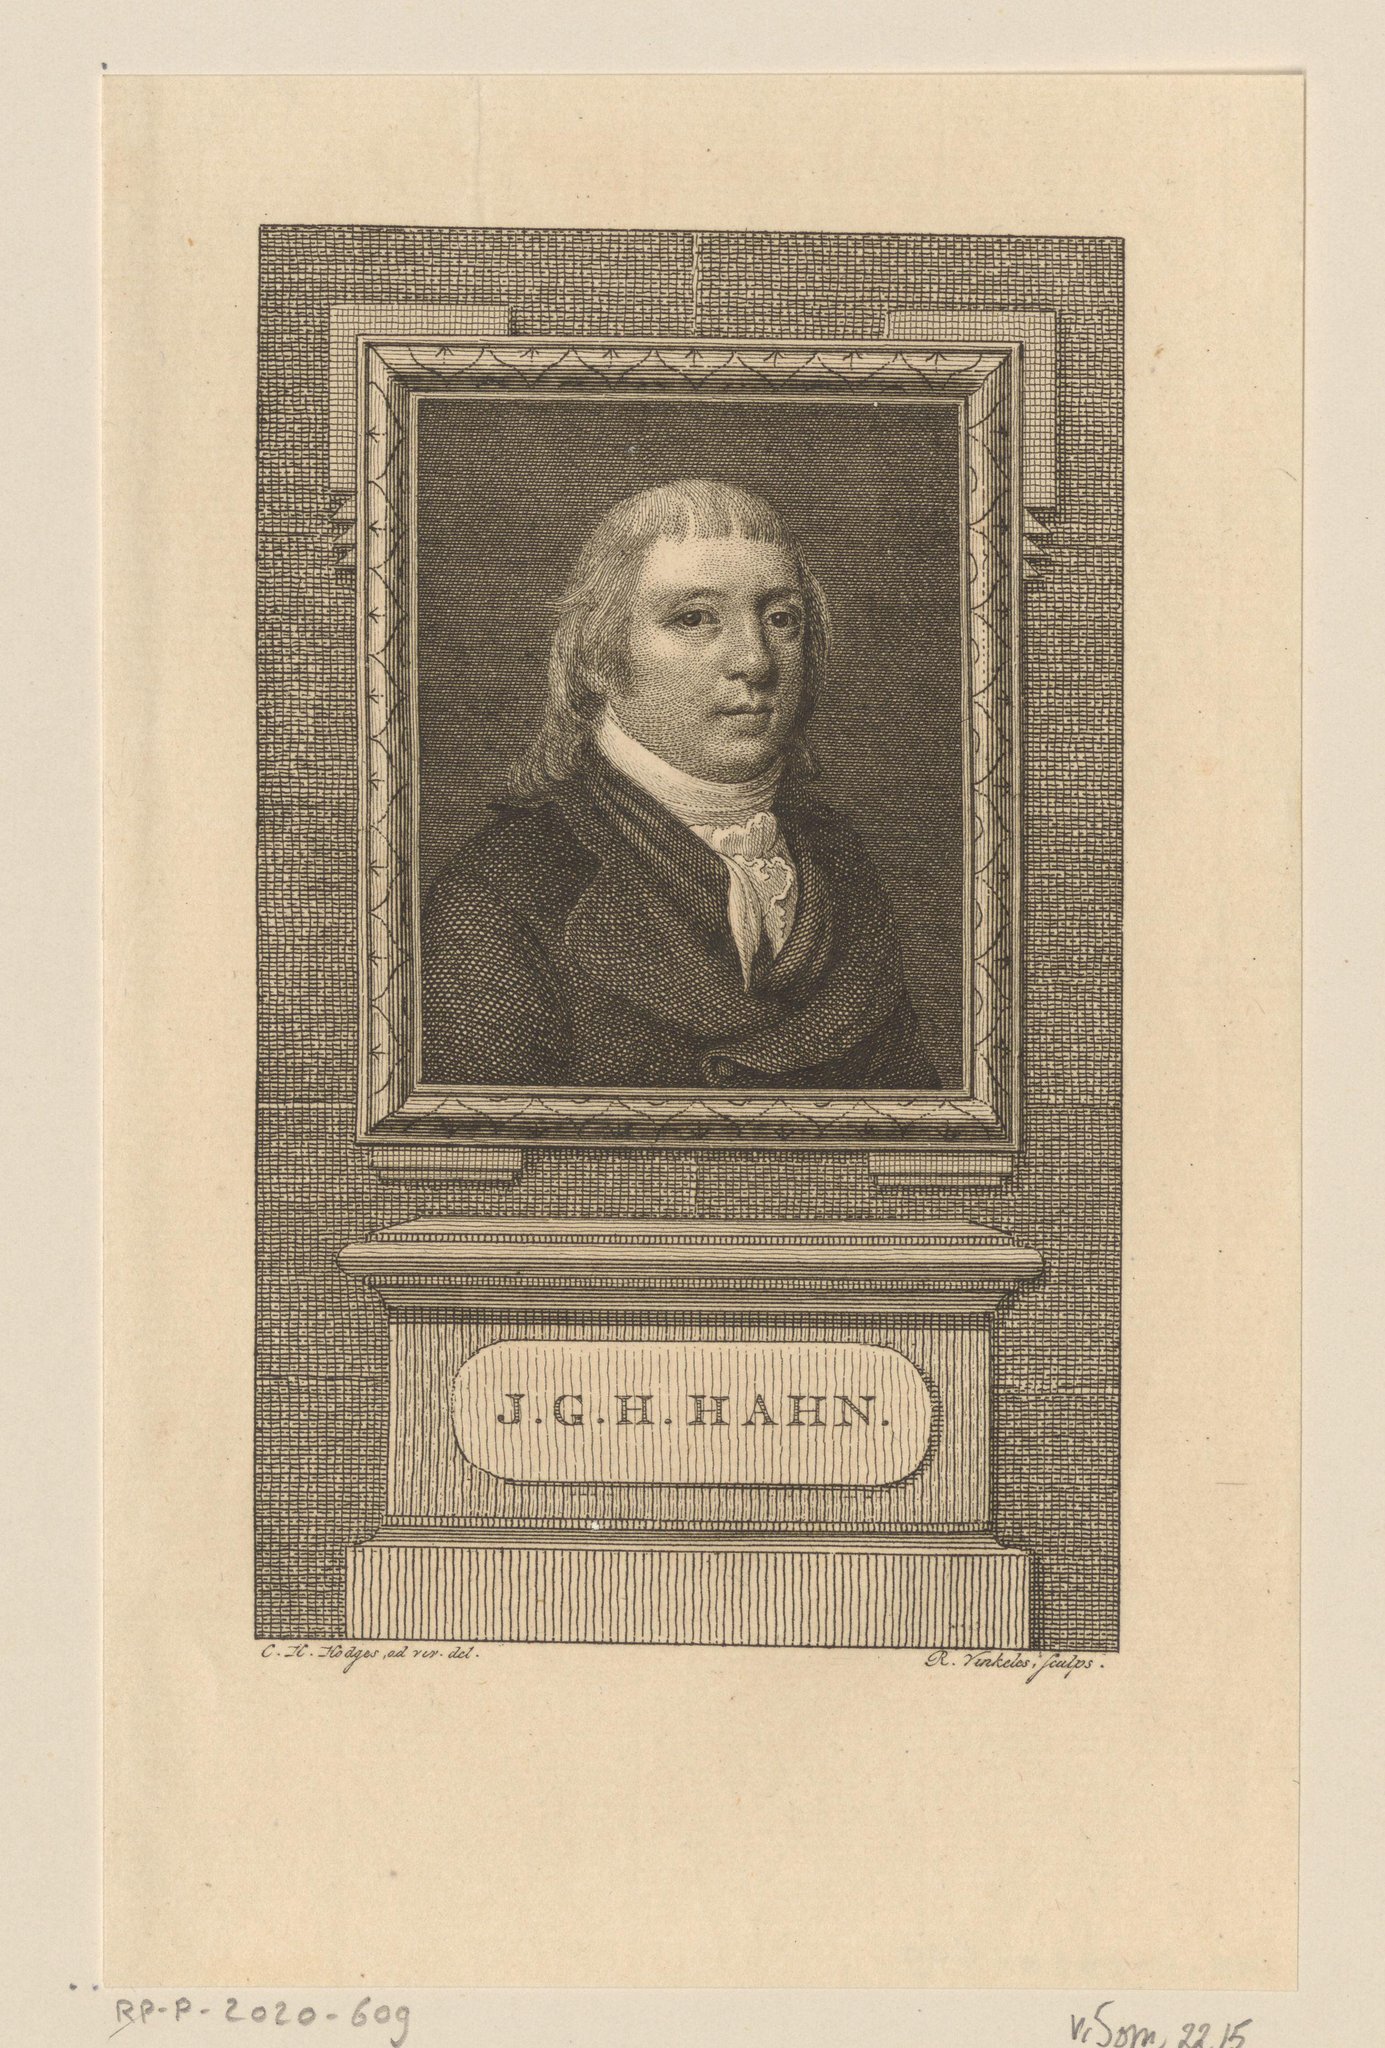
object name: print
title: Portret van Jacob George Jeronimo Hahn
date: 1786-1811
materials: paper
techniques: engraving, etching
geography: amsterdam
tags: historical persons, politician, e.g. party leader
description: Prent gebruikt in: Loosjes, Petrus. Vaderlandsche historie, (...) ten vervolge van Wagenaars Vaderlandsche historie. Amsterdam: Johannes Allart, 1786-1811, dl. 29. Ook gebruikt in latere edities van dit werk.